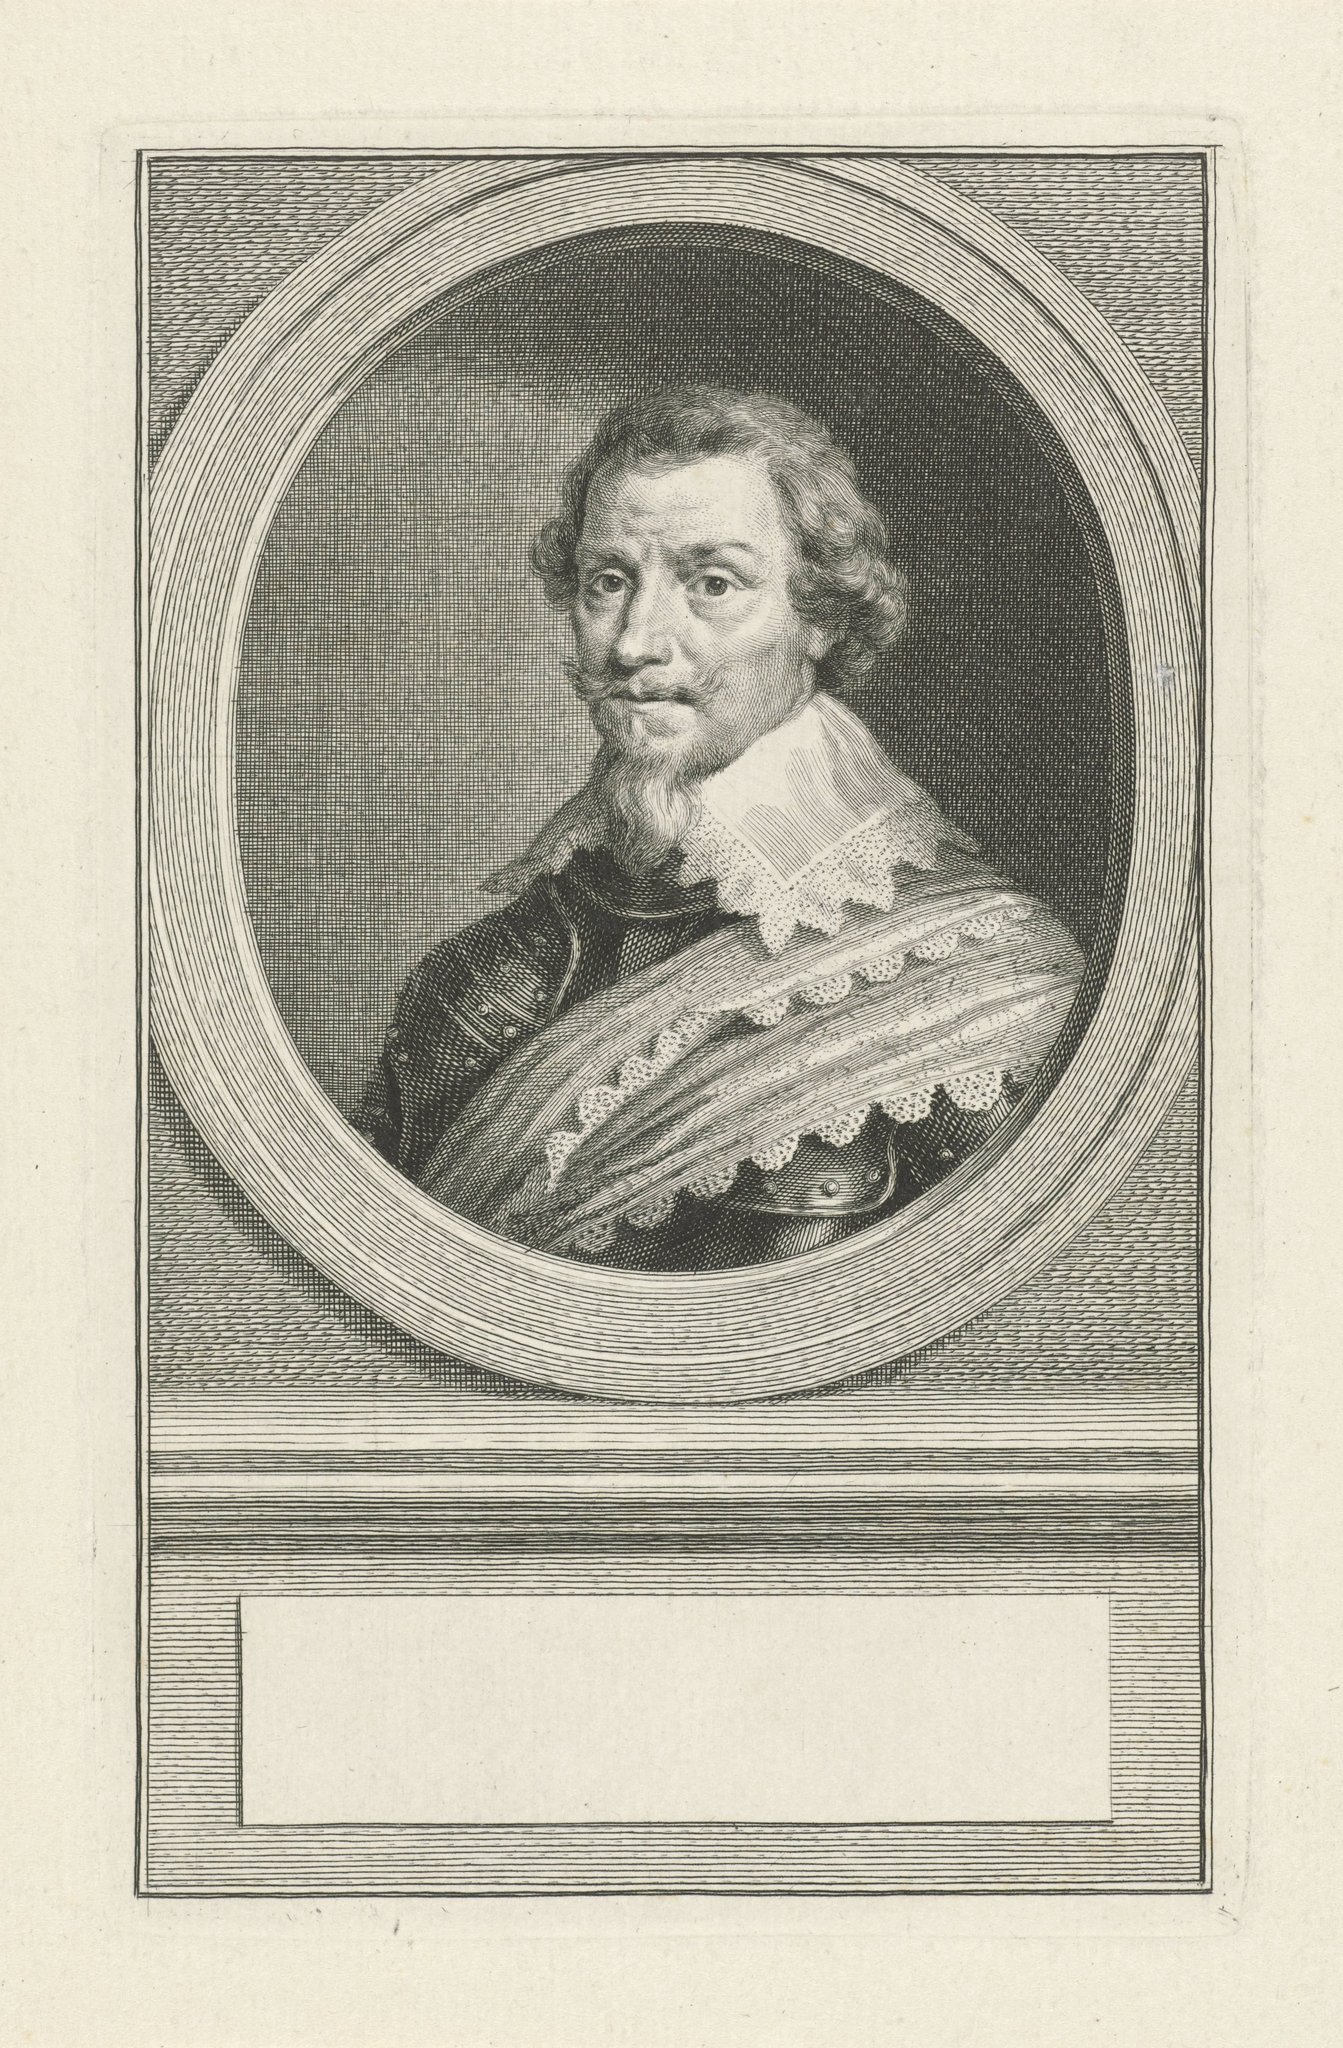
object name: print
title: Portret van Ernst Casimir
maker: jacob houbraken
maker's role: draughtsman, print maker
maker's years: 1698-1780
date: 1747-1759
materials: paper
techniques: engraving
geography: amsterdam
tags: ernst casimir graaf van nassau-dietz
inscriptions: collector's mark: Lugt 2228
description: Proefdruk van prent gebruikt in: Jan Wagenaar, Vaderlandsche historie, vervattende de geschiedenissen der nu Vereenigde Nederlanden, inzonderheid die van Holland (...), 21 delen. Amsterdam, Isaak Tirion, 1749-59.